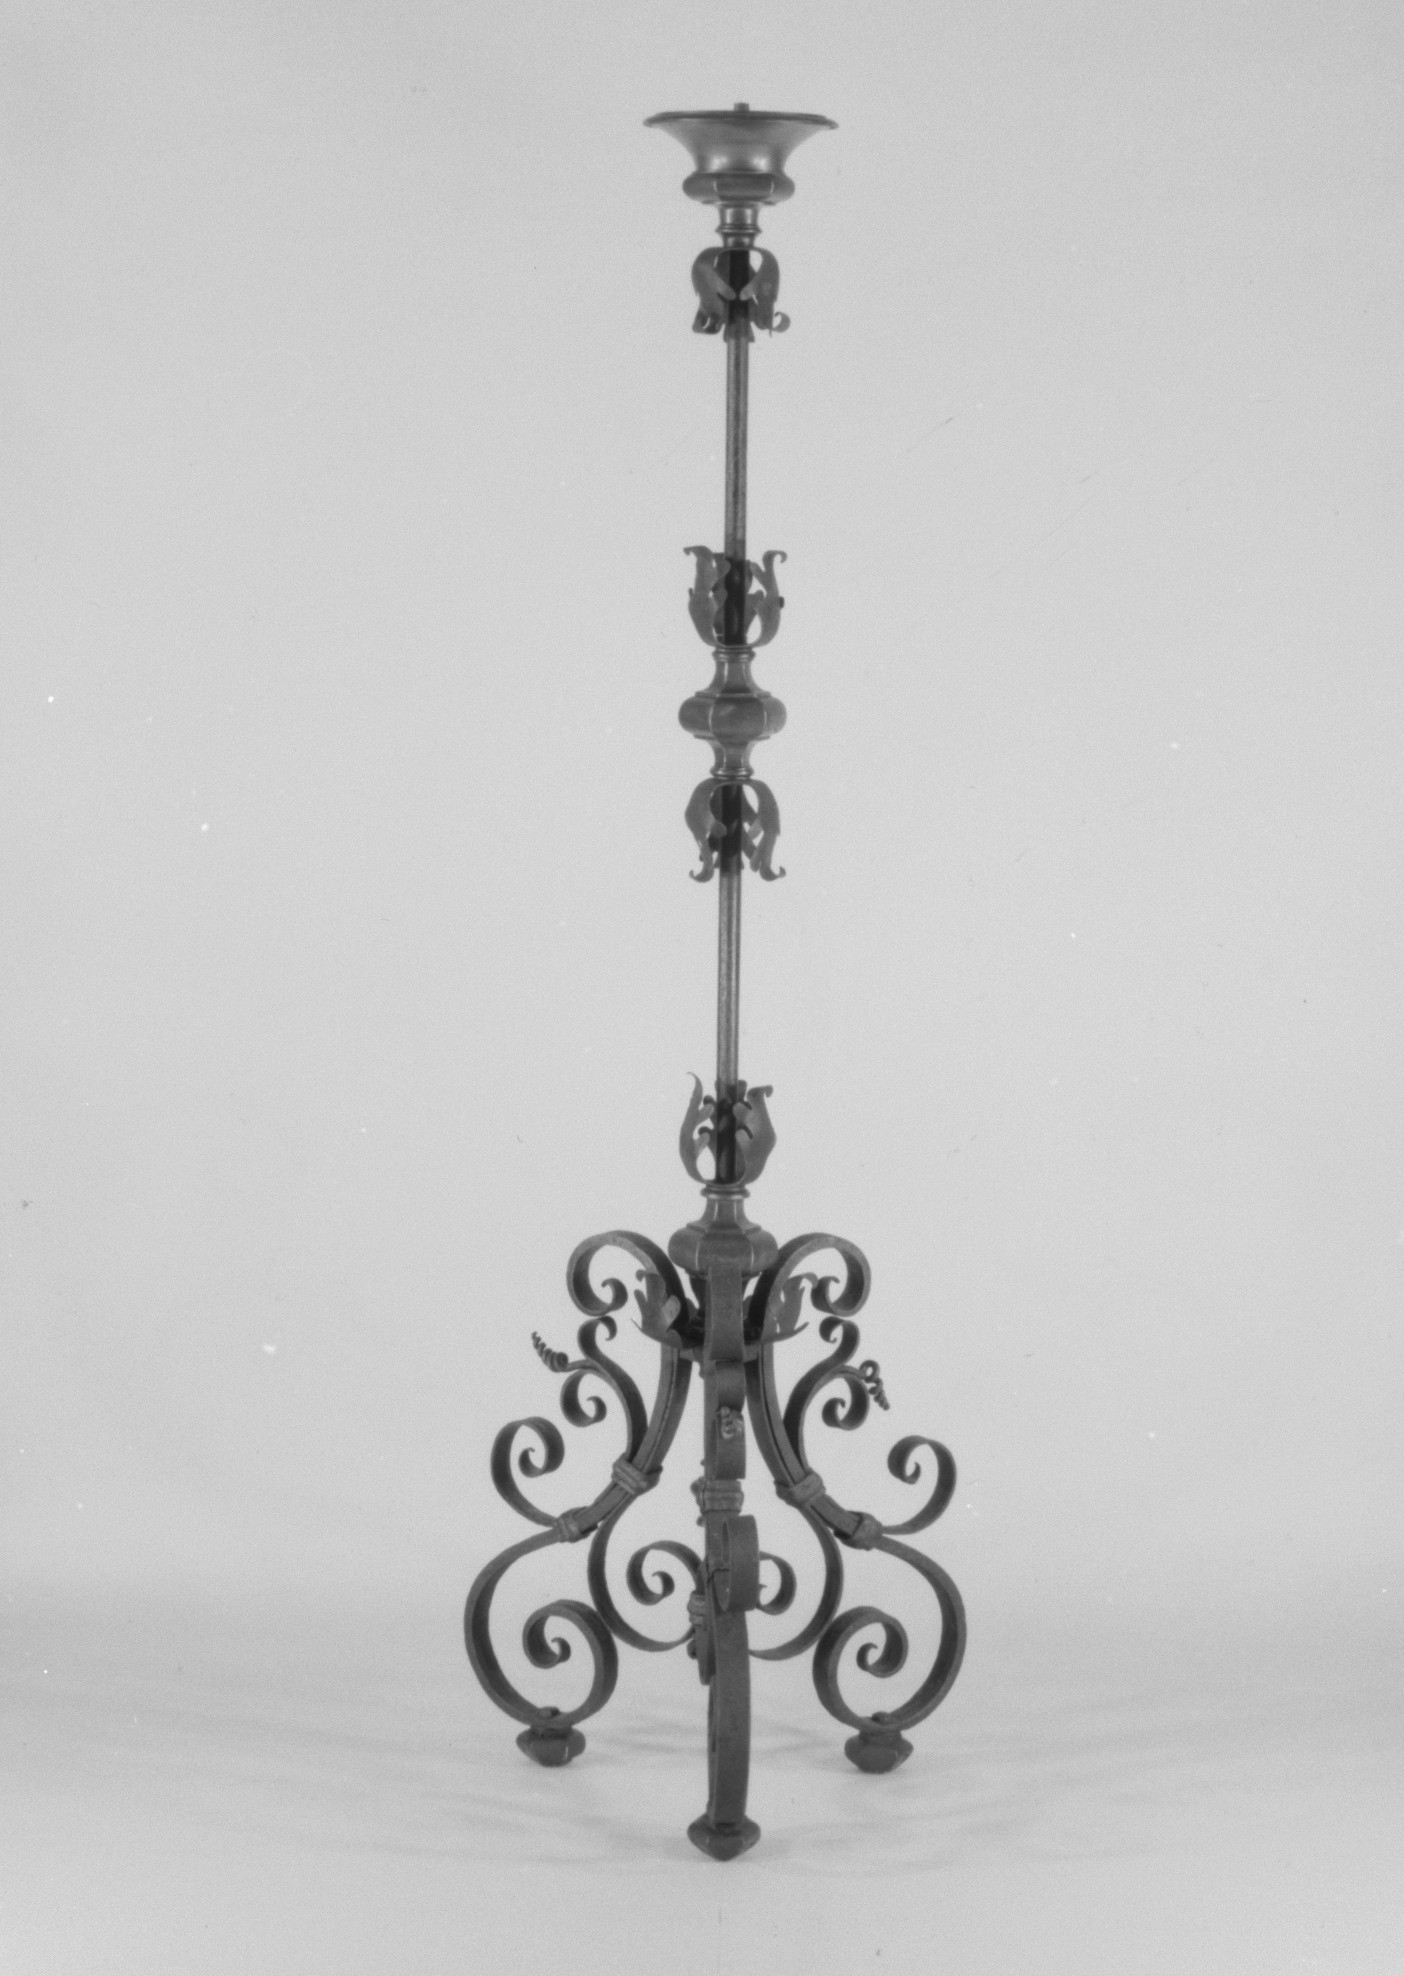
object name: candlestick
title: Pair of candlesticks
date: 1651-1700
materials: iron